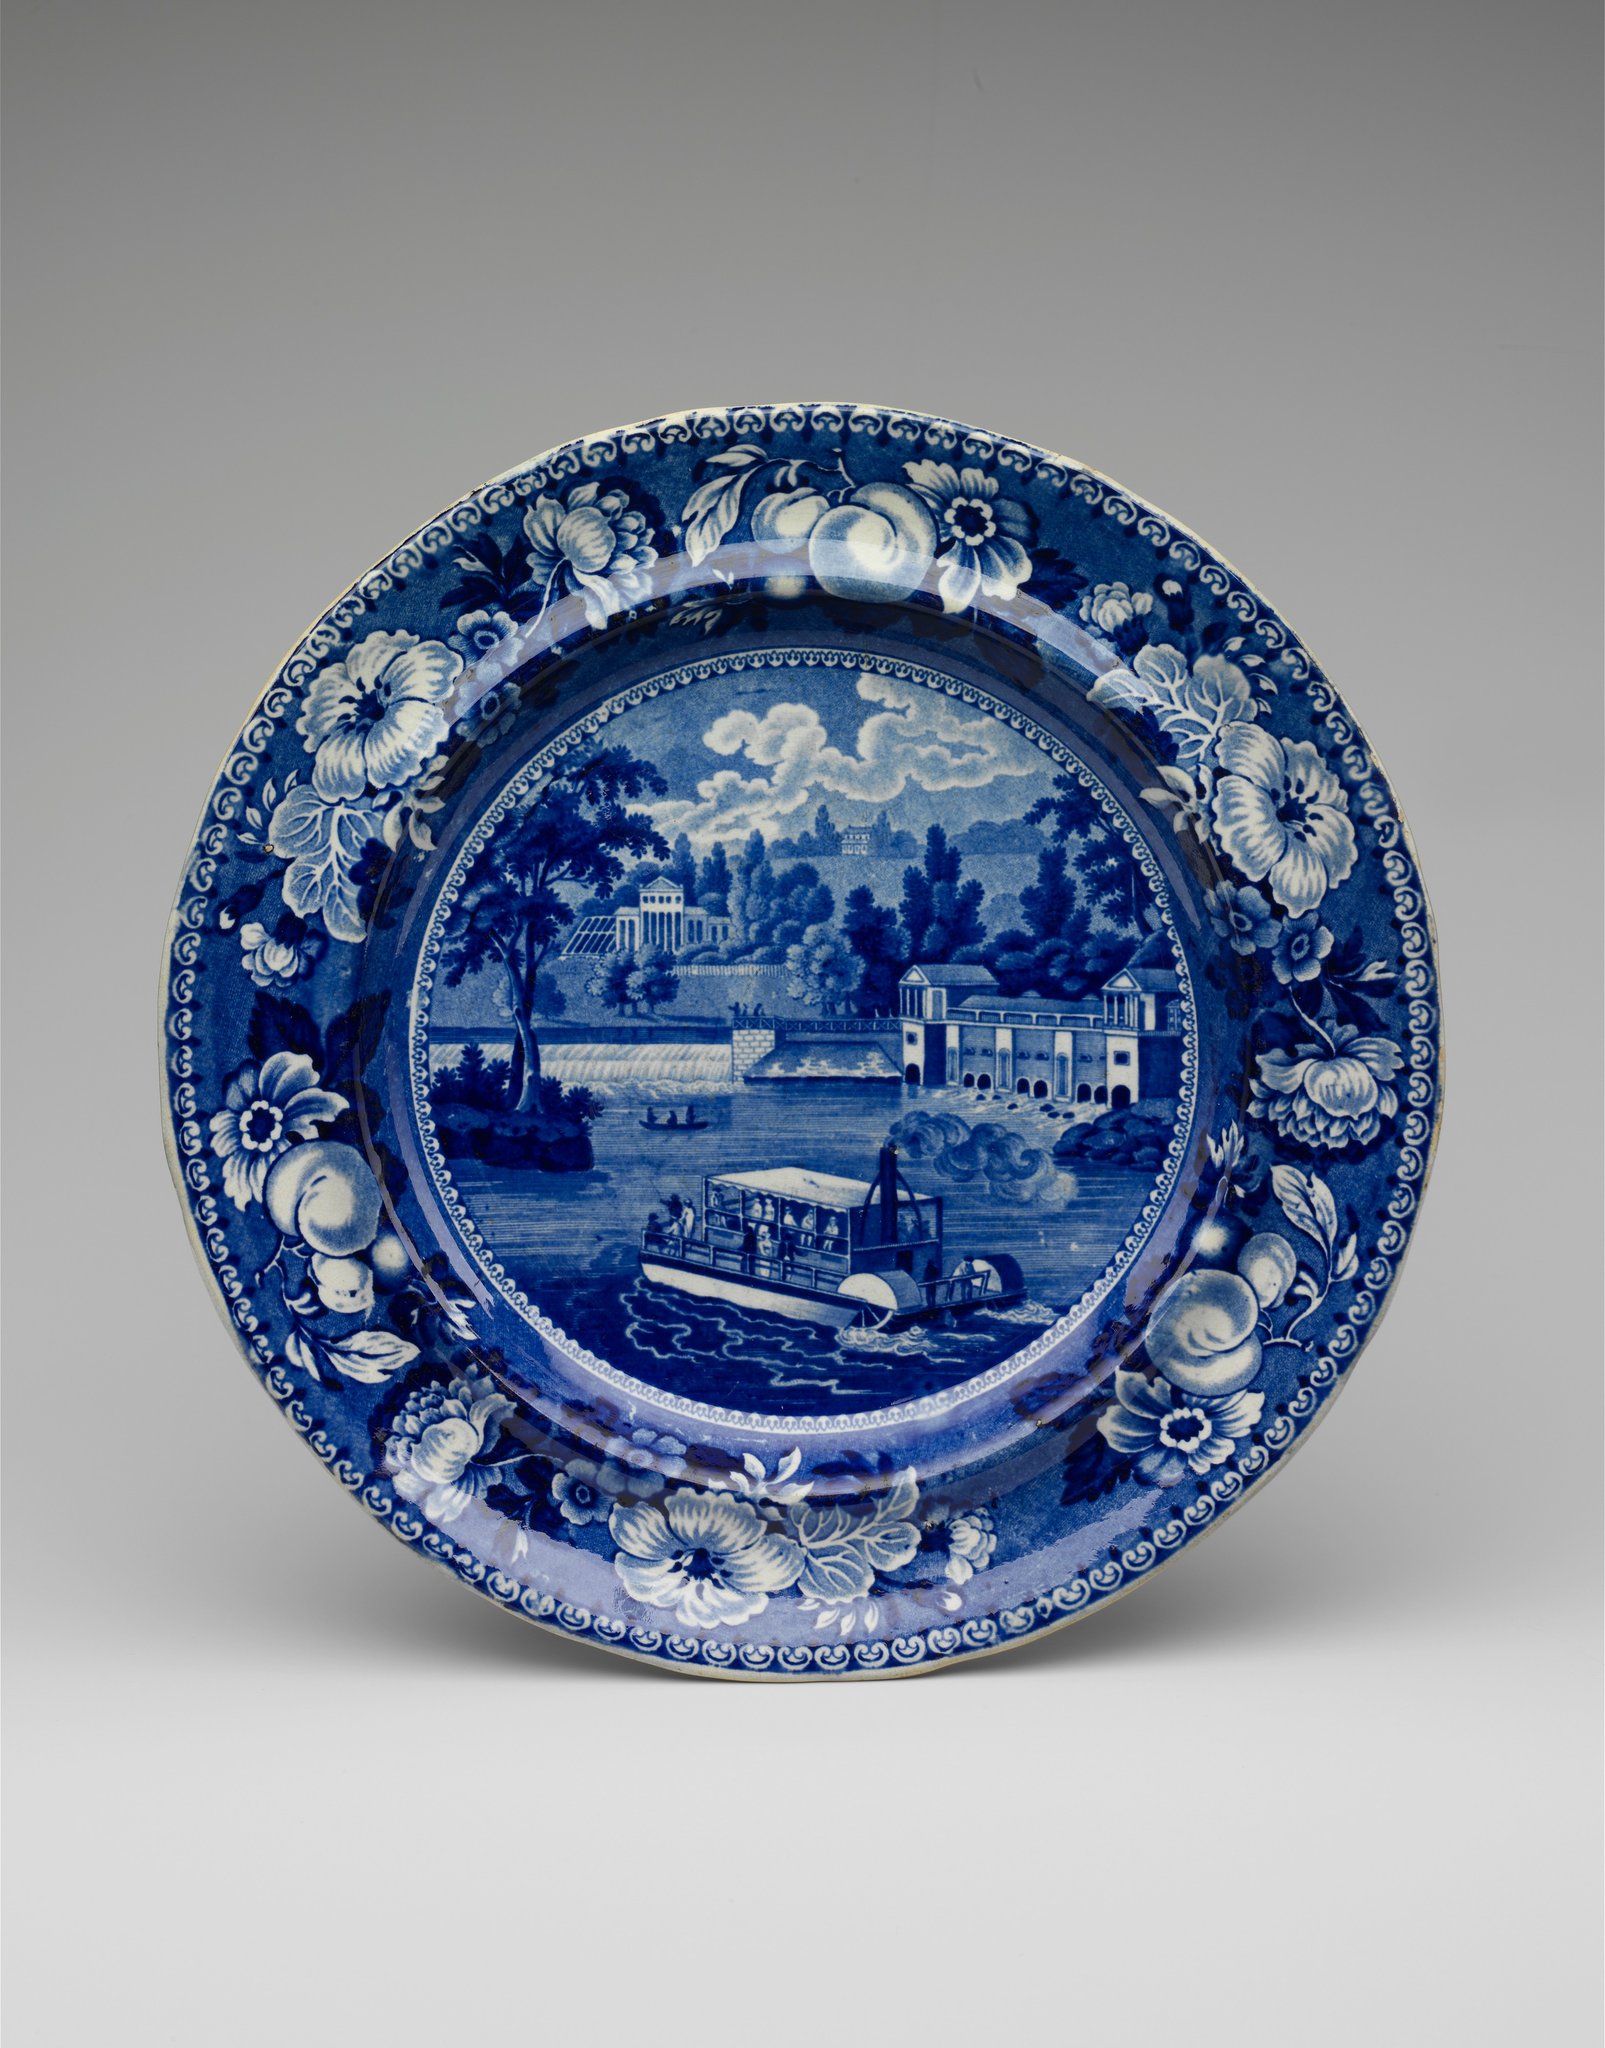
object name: plate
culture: british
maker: henshall, williamson & co.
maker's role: maker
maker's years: 1799-1828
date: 1824-1828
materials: earthenware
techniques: transfer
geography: england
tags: flowers,landscapes,boats